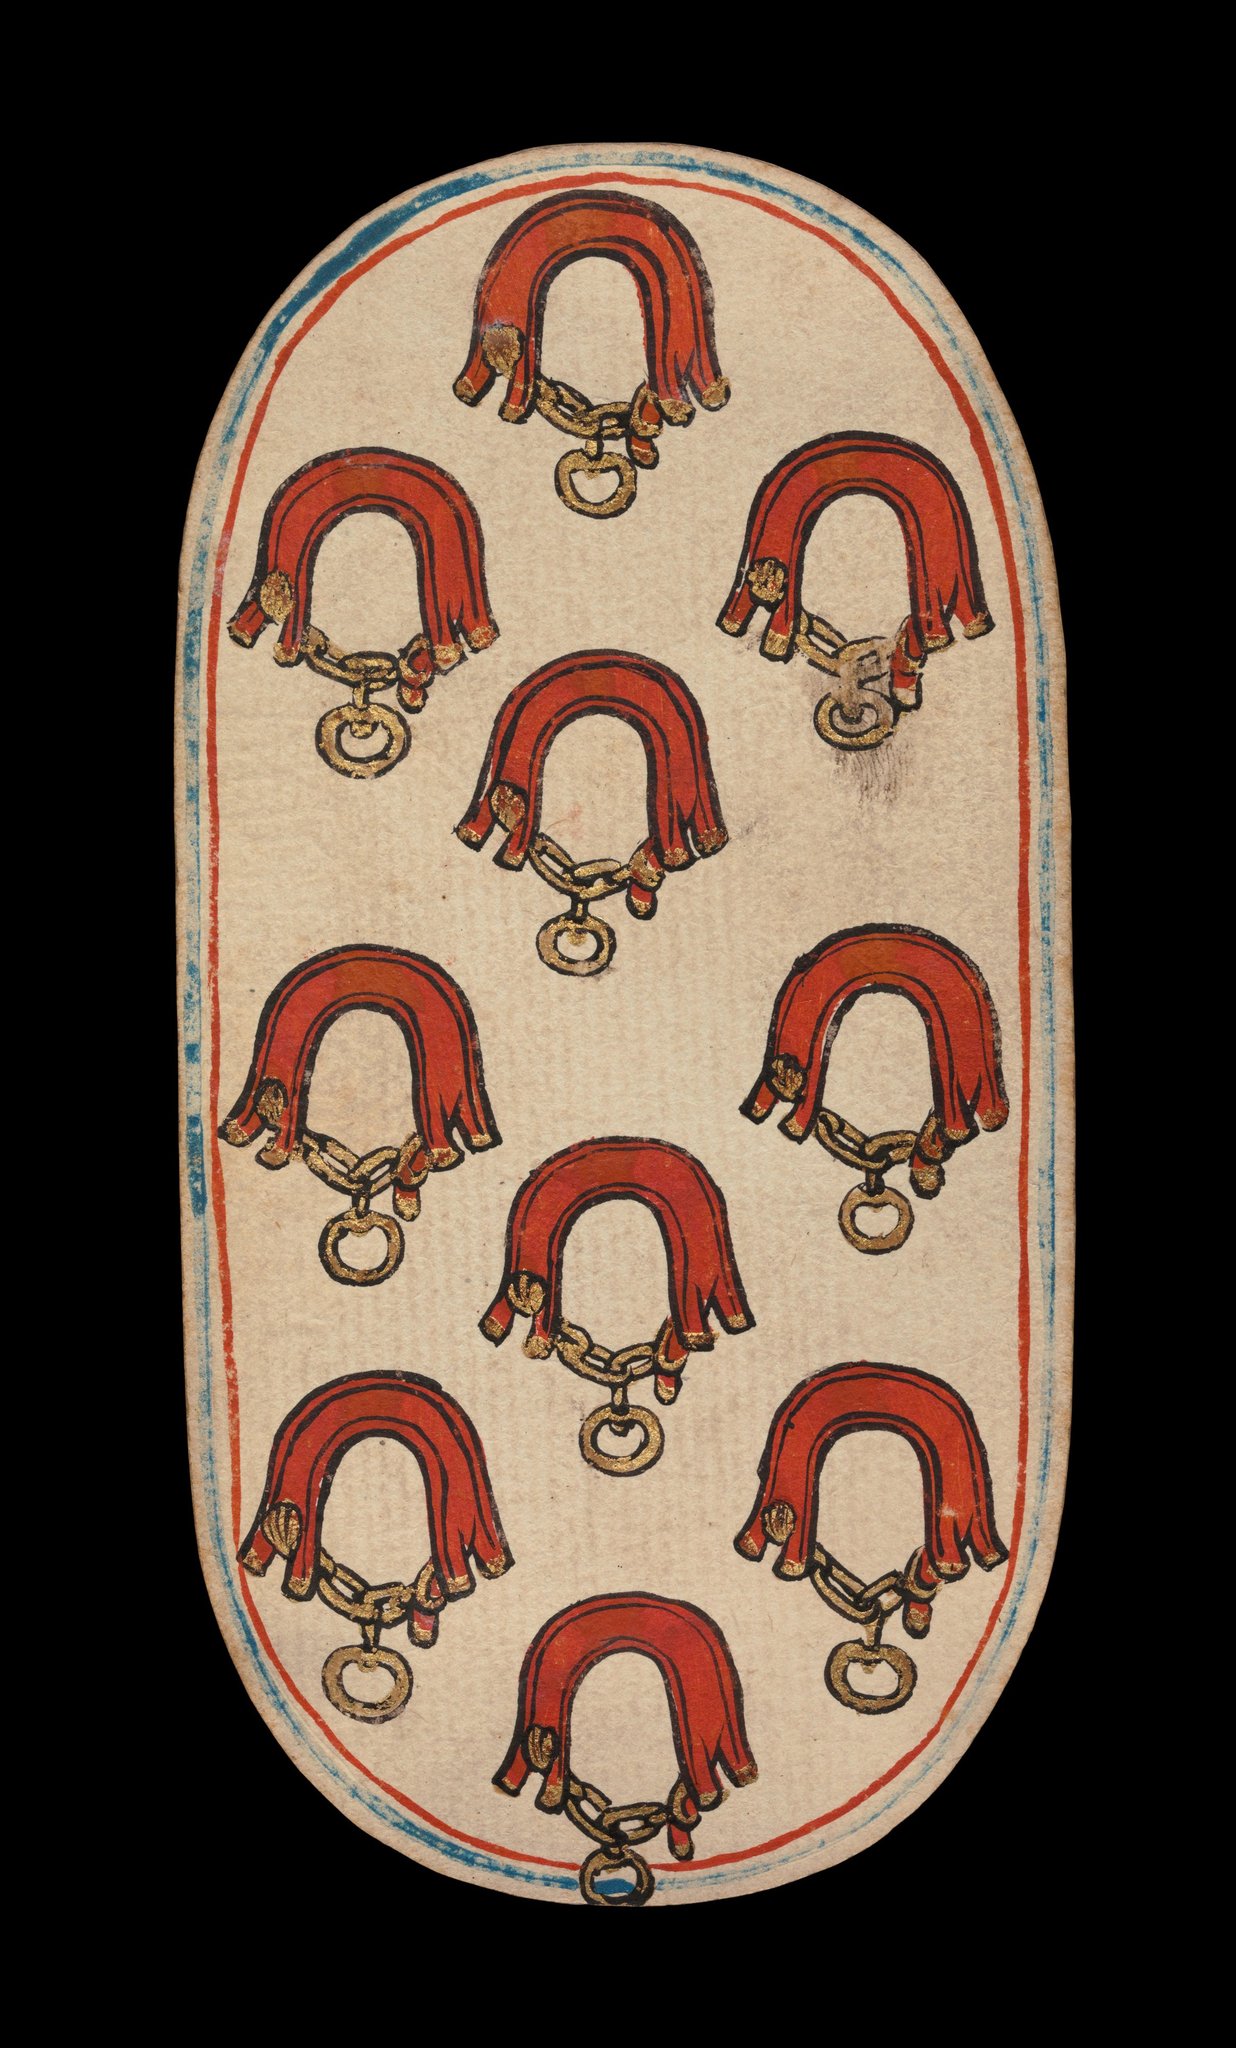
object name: playing card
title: 10 of Collars, from The Cloisters Playing Cards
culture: south netherlandish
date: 1475-1480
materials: glaze, gold, ink, paint, paper, silver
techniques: pen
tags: playing cards,games